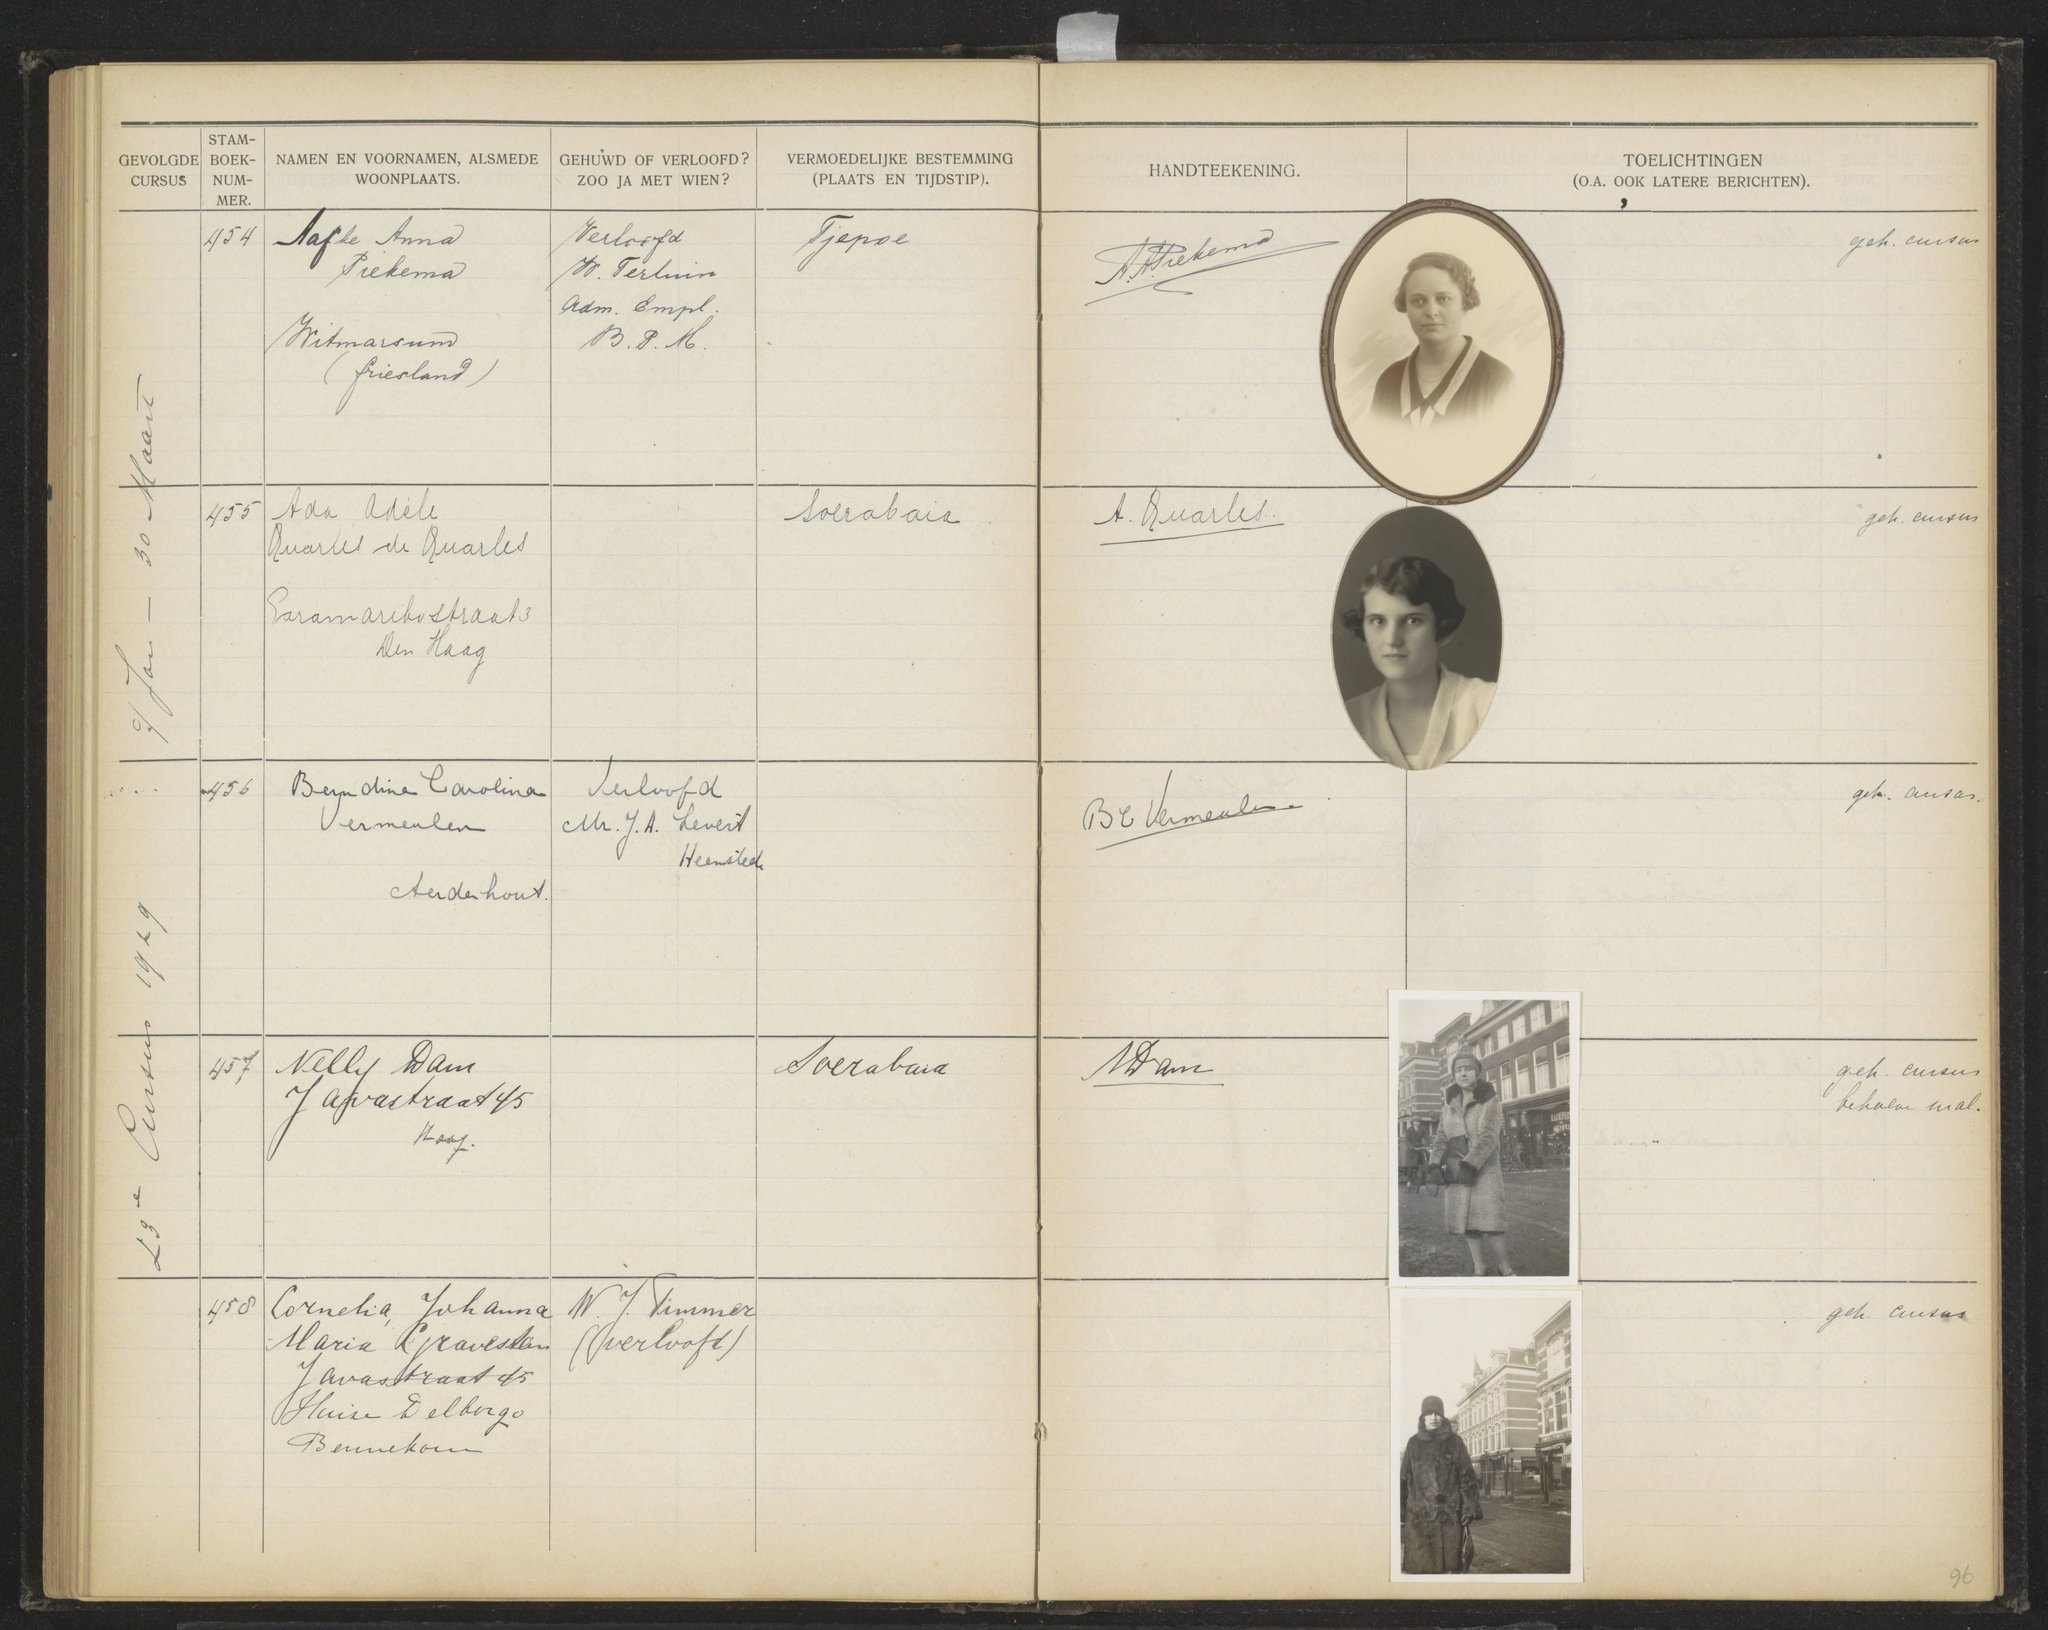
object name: photograph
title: Blad 96 uit Stamboek van de leerlingen der Koloniale School voor Meisjes en Vrouwen te 's-Gravenhage deel I (1921-1929)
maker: Anonymous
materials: paper, photographic support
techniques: photography, printing, writing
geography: the hague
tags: further education (+ pupil), further education, the hague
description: Twee pagina's met gegevens van de deelnemers aan de 23e driemaandelijkse cursus van 7 januari tot en met 30 maart 1929, stamboeknummers 454 tot en met 458. Onderdeel van Stamboek van de leerlingen der Koloniale School voor Meisjes en Vrouwen te 's-Gravenhage deel I (1921-1929).